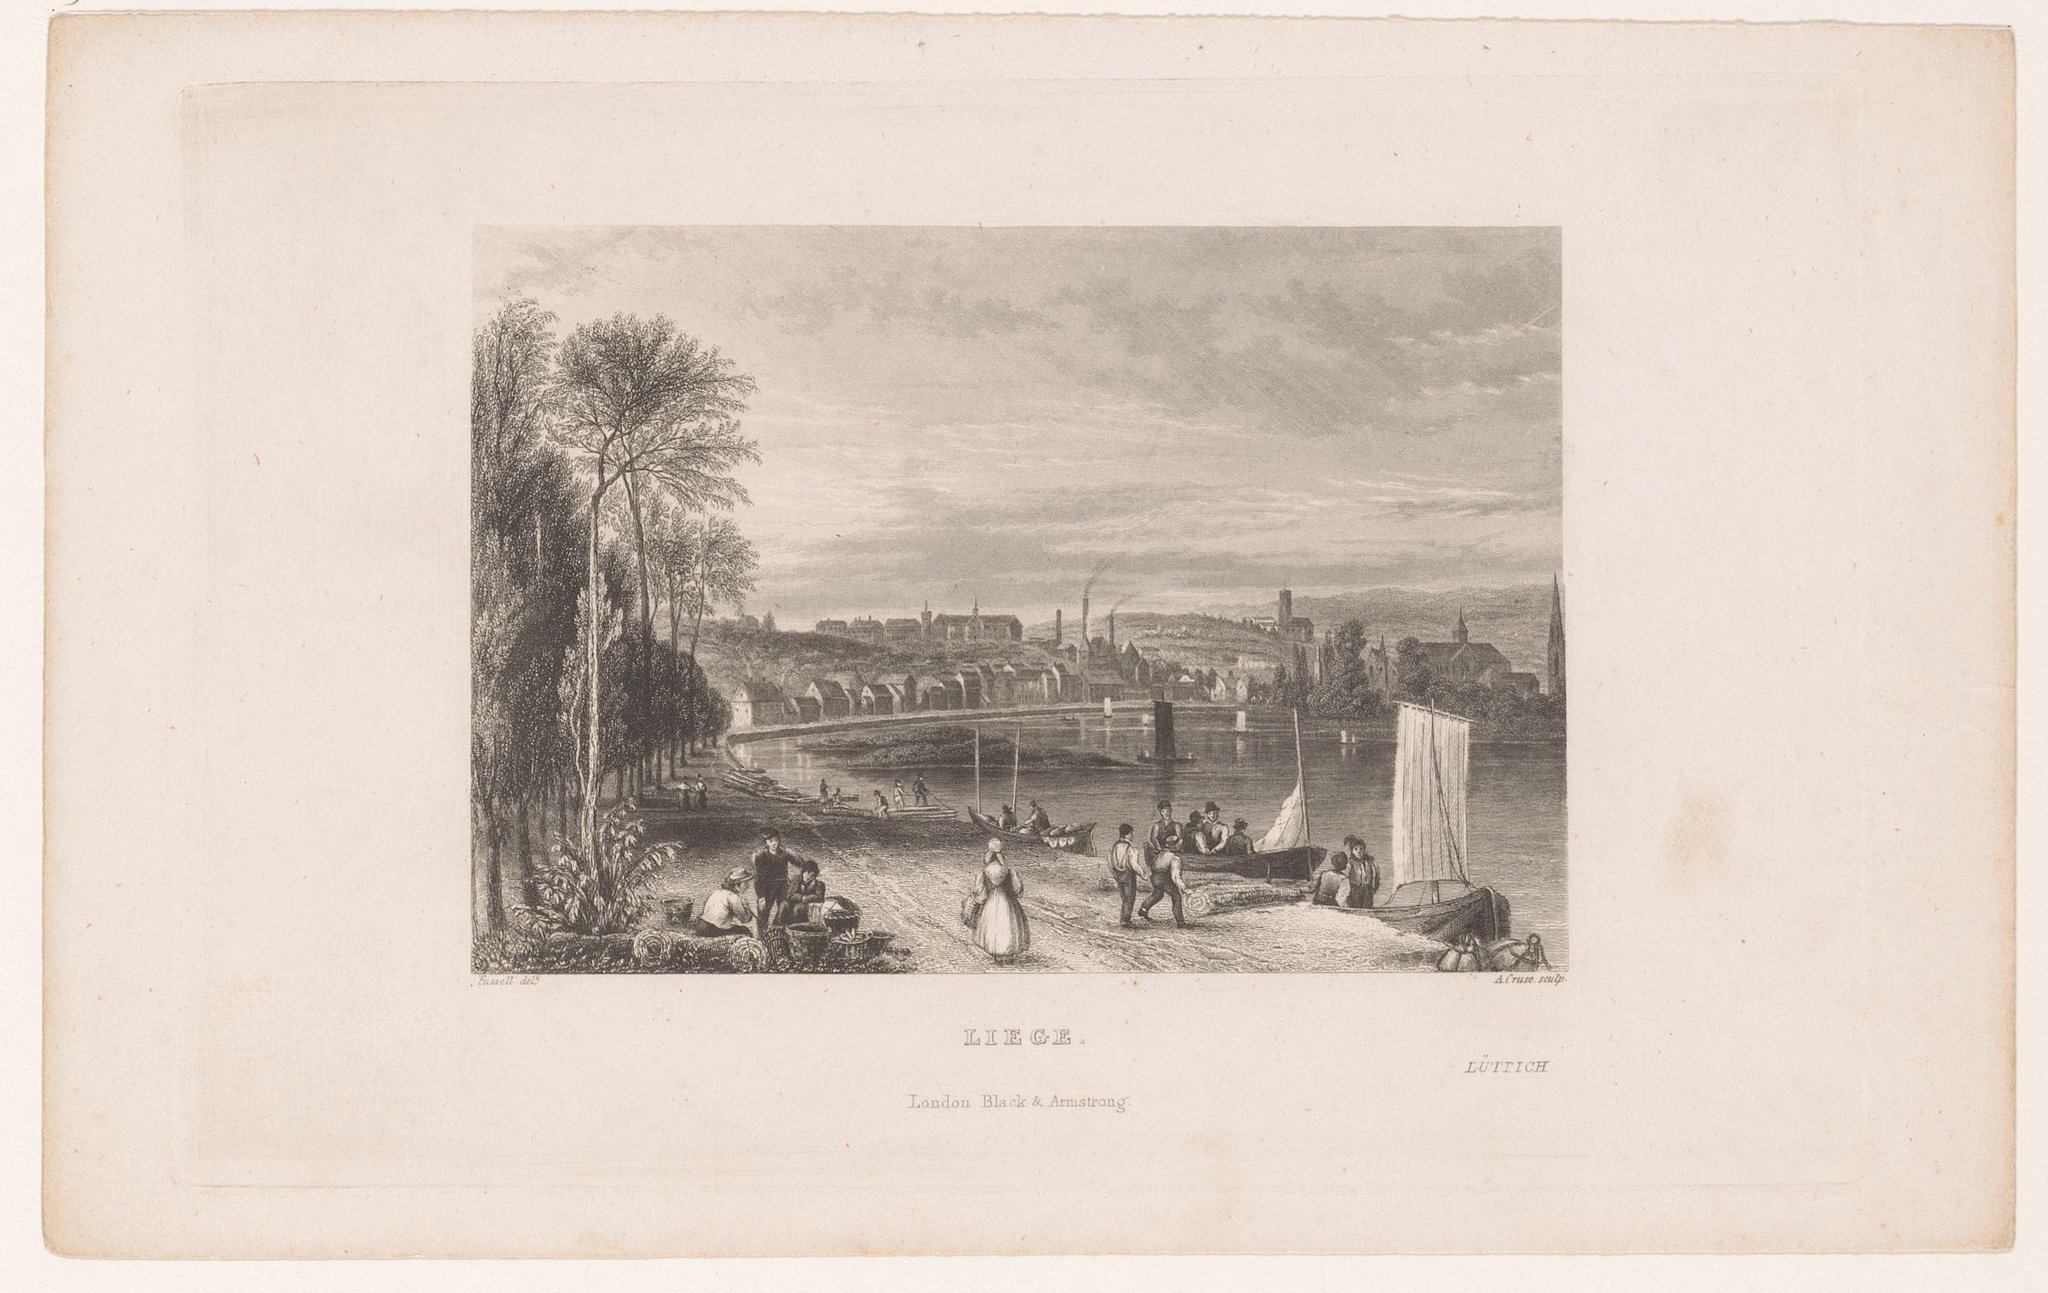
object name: print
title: Liege / Lüttich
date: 1838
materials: paper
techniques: engraving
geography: london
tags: city-view in general; 'veduta', bridge in city across river, canal, etc., liège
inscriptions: collector's mark: Lugt 2233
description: Prent uit: Belgium and Nassau; or, the continental tourist. London: Black & Armstrong, [1838].